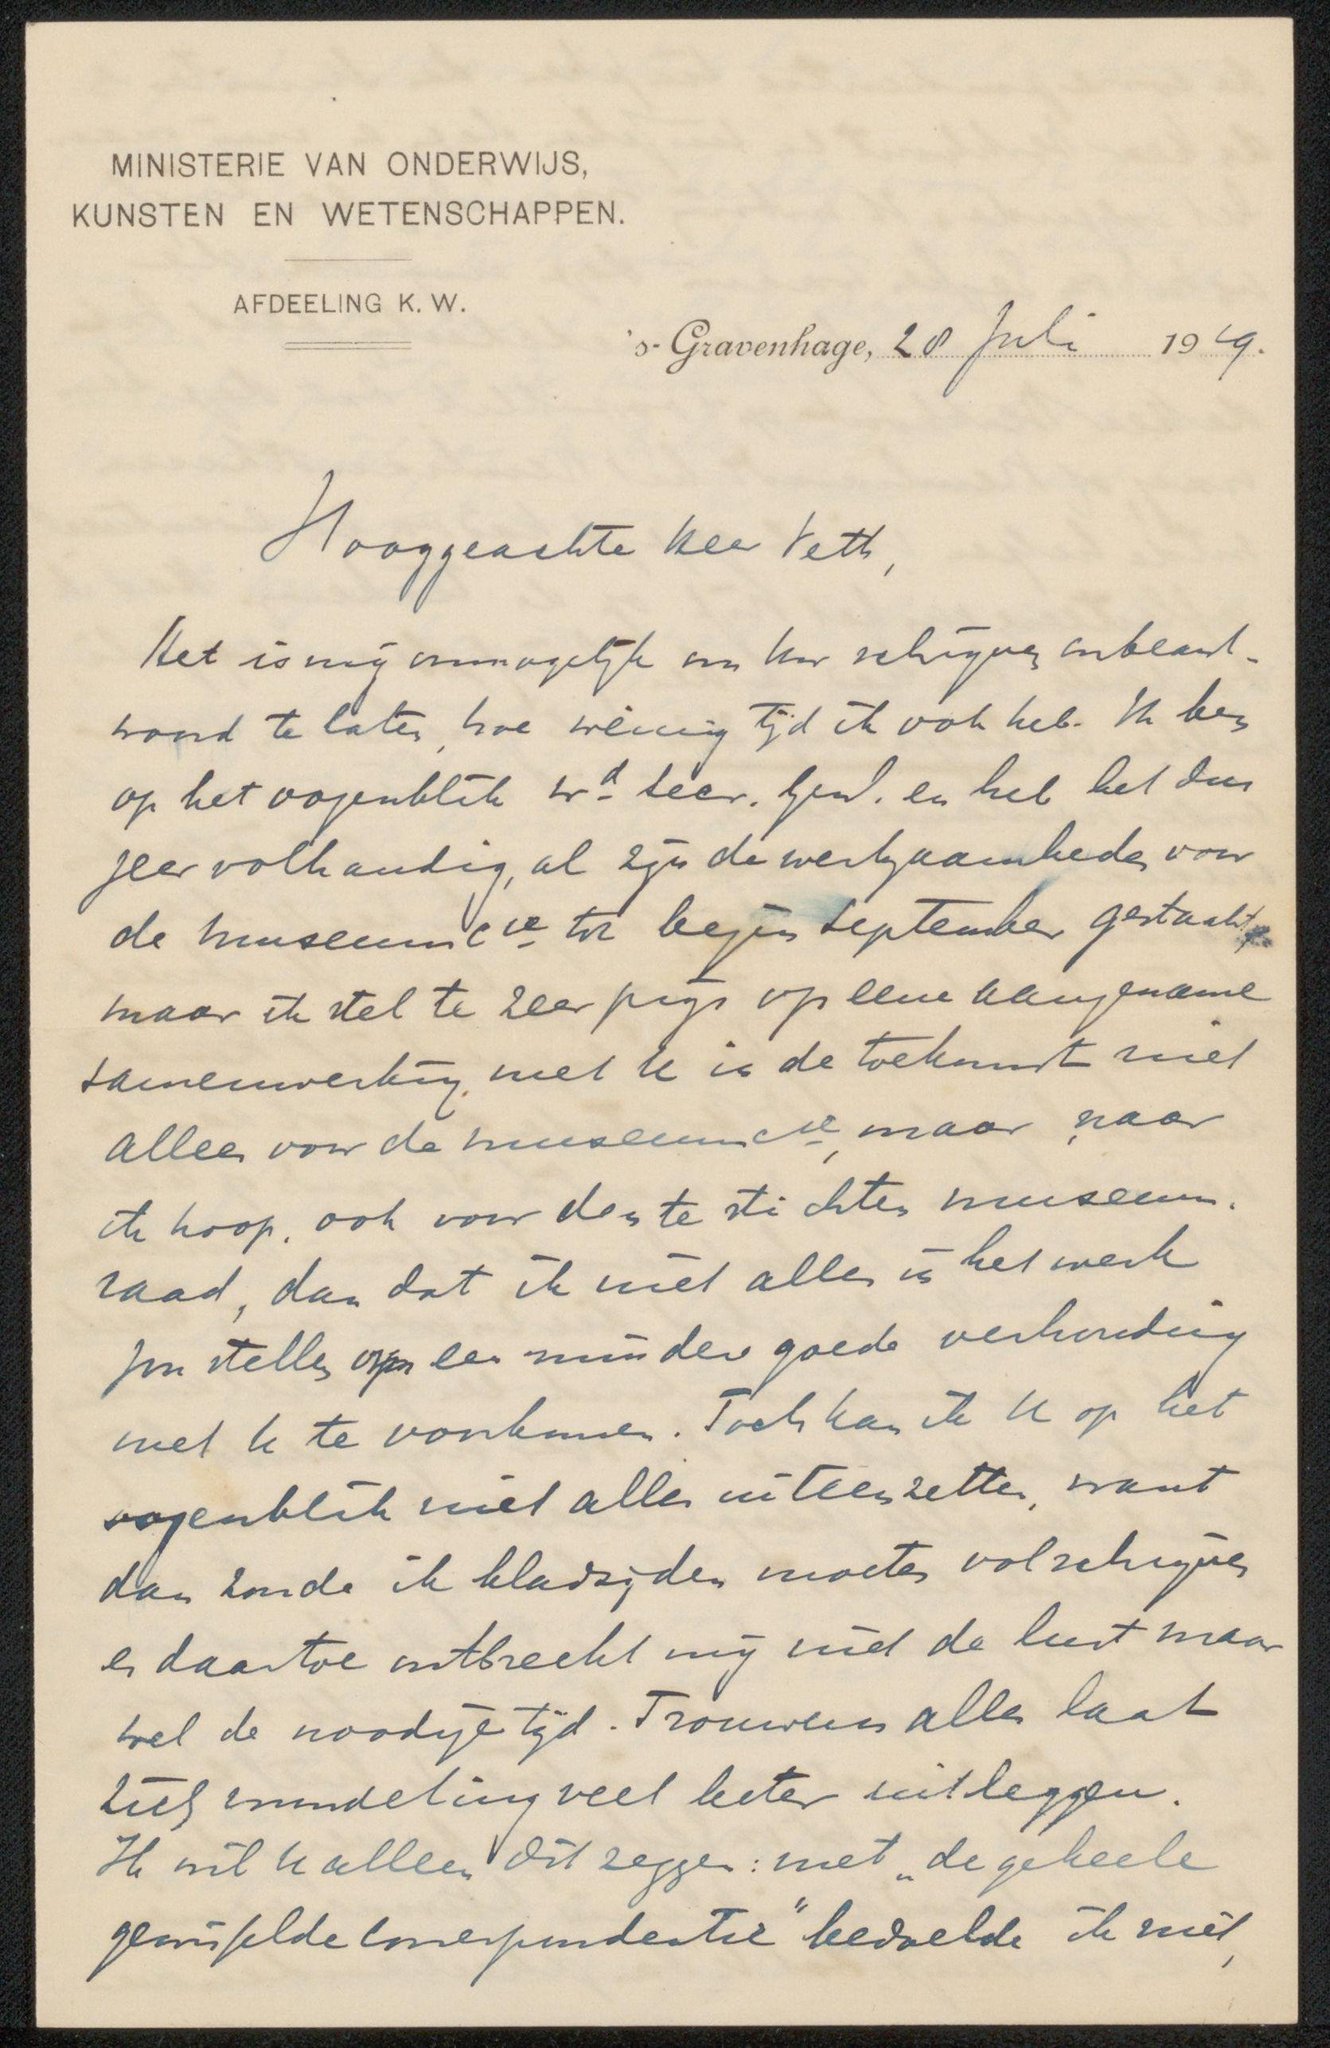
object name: letter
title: Brief aan Jan Veth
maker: mozes isaac duparc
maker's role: jurist, referendaris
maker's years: 1870-1925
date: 1919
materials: ink, paper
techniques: pen, printing, writing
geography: the hague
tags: dordrecht, amsterdam, painter, print maker, draughtsman, designer, jan veth, christiaan pieter van eeghen (1880-1968)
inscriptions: collector's mark: ‘RPK’